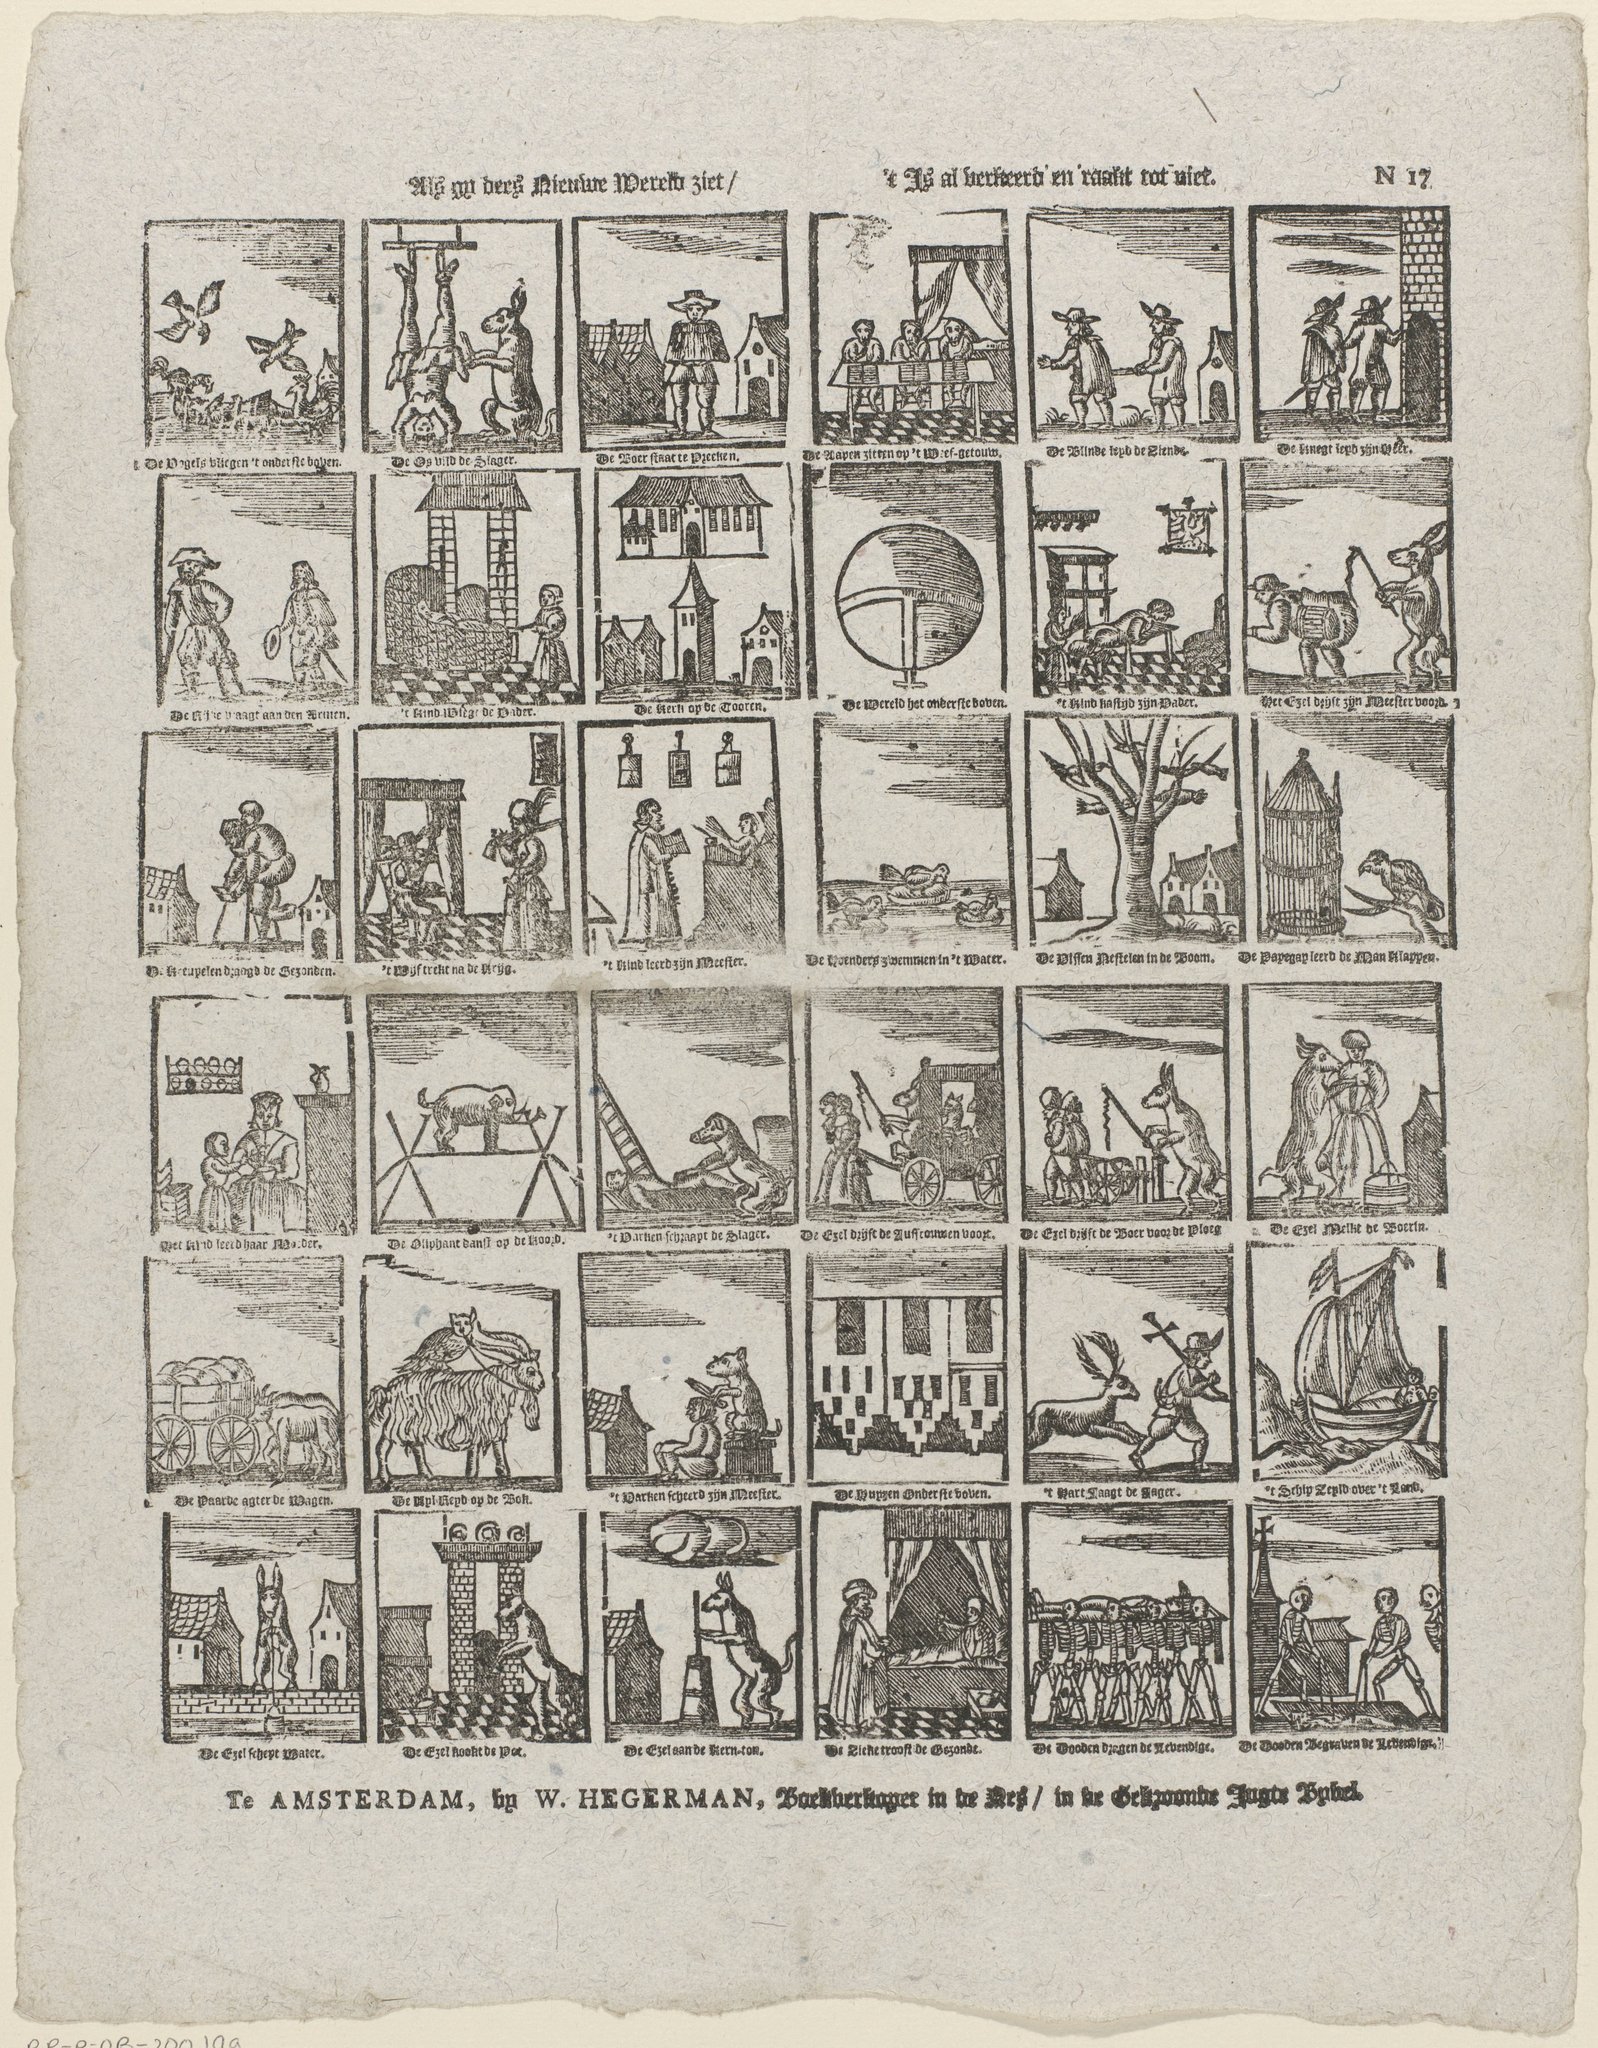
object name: print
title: Als hy dees nieuwe wereld ziet / 't is al verkeerd' en 'raakt tot niet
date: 1761-1781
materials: paper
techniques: letterpress printing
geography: amsterdam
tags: 'mundus inversus', the reversed world, the topsy-turvy world, 'le monde bestourné', animals acting as human beings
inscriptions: collector's mark: Lugt 2228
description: Blad met 36 voorstellingen over de verkeerde wereld, waar onder andere dieren zich als mensen gedragen. Onder elke afbeelding een onderschrift. Genummerd rechtsboven: N 17.